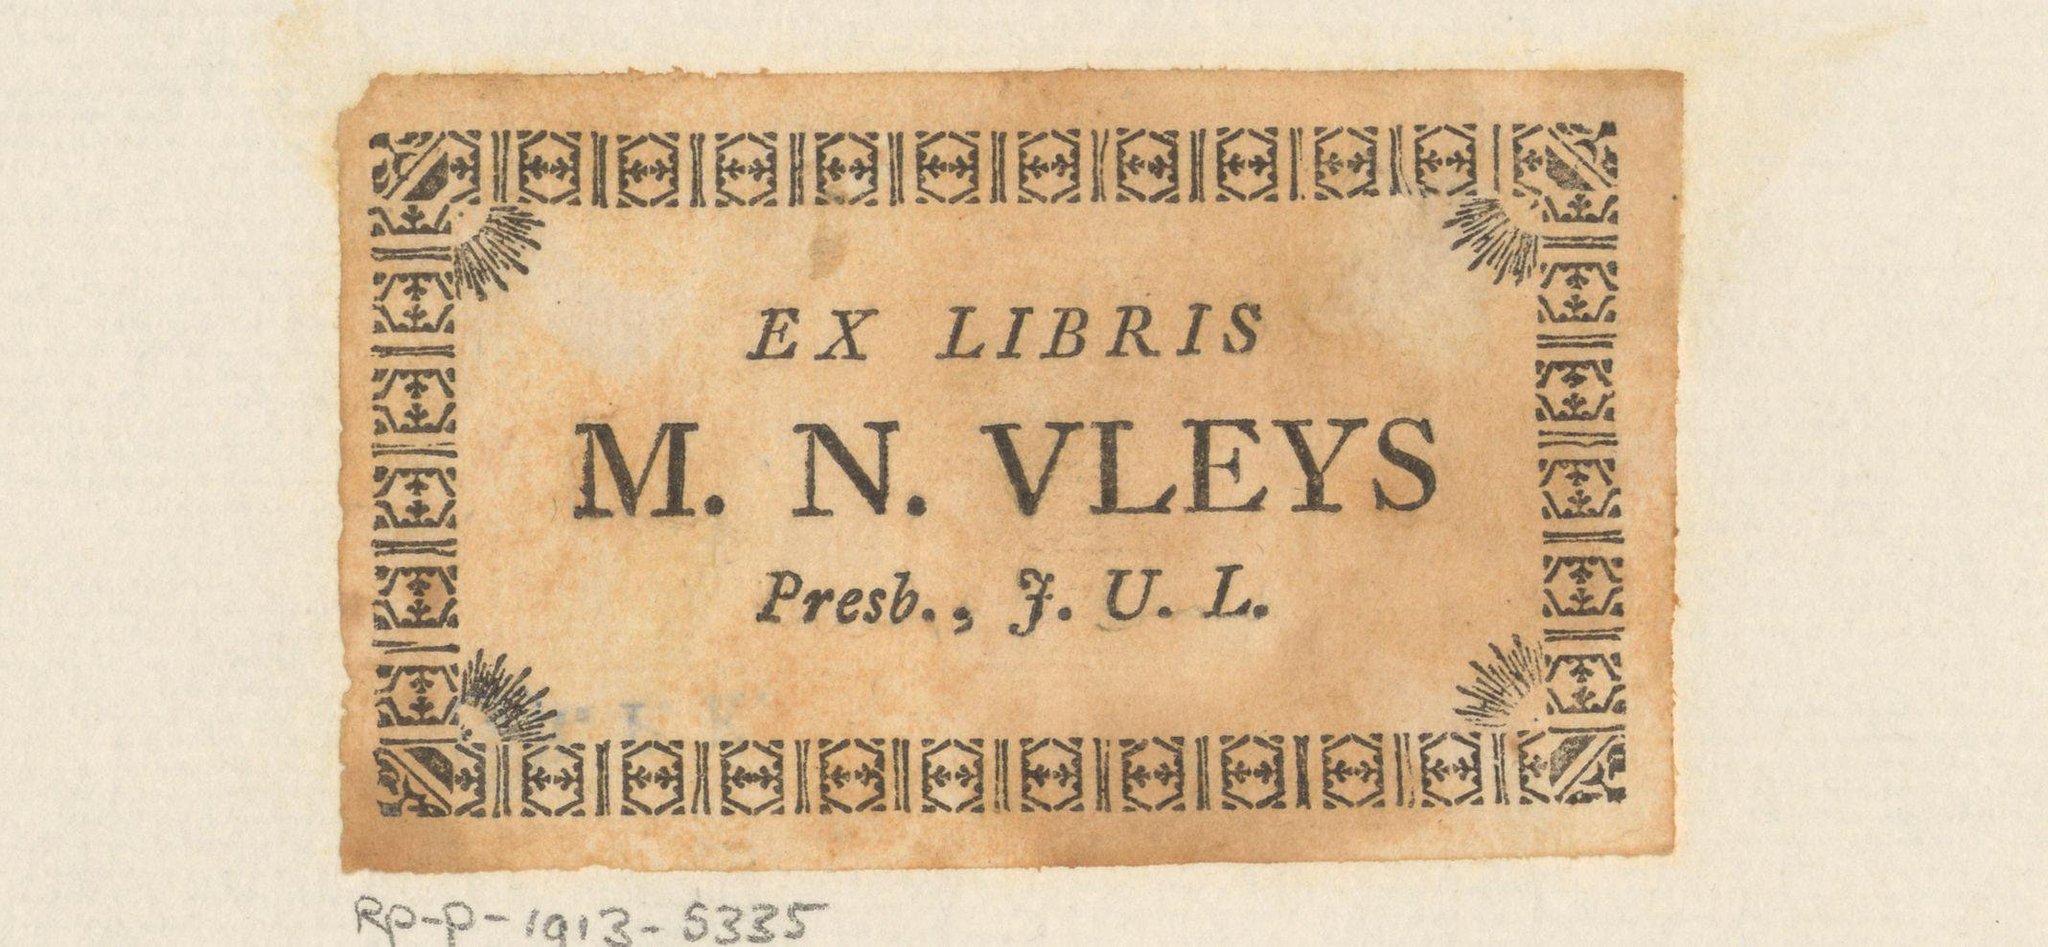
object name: bookplate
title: Ex libris van M.N. Vleys Presb., J.U.L.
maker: Anonymous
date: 1800-1899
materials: paper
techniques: letterpress printing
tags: m.n. vleys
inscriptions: collector's mark: Lugt 2760, collector's mark: Lugt 2233